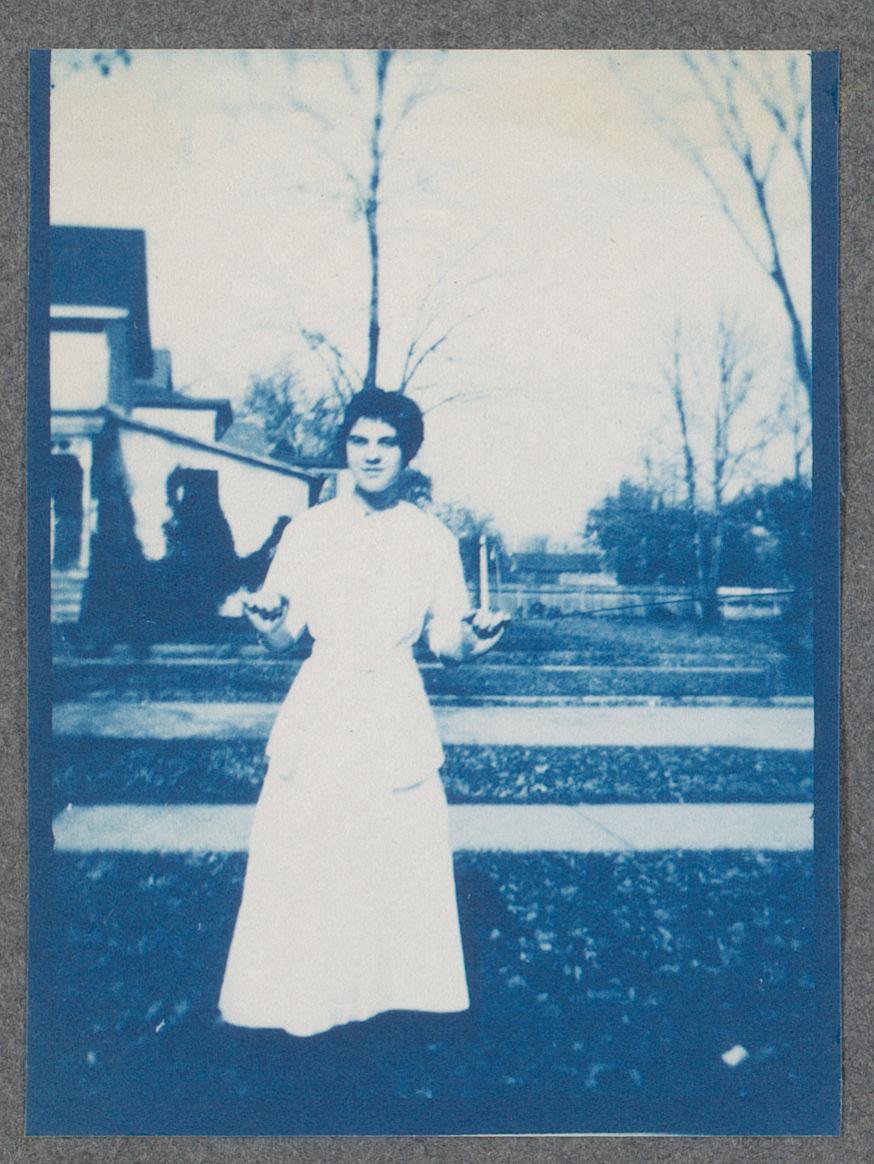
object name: photograph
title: Studente op straat, mogelijk op de campus van Denison University in Ohio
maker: Anonymous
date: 1910-1920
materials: paper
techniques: cyanotype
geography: granville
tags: student - bb - female student